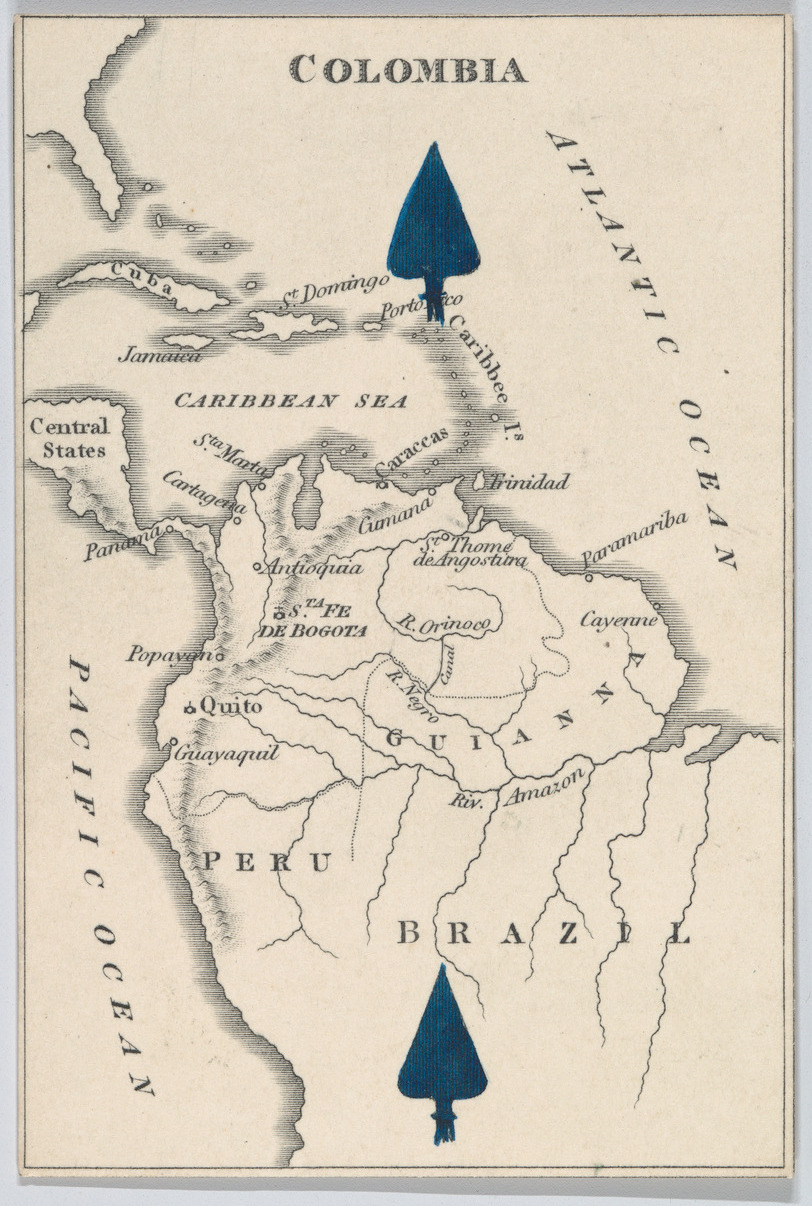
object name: print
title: Colombia, from "Court Game of Geography"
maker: william and henry rock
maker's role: publisher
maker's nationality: british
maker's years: 1821-1884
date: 1838-1855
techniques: engraving, hand coloring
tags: playing cards,maps